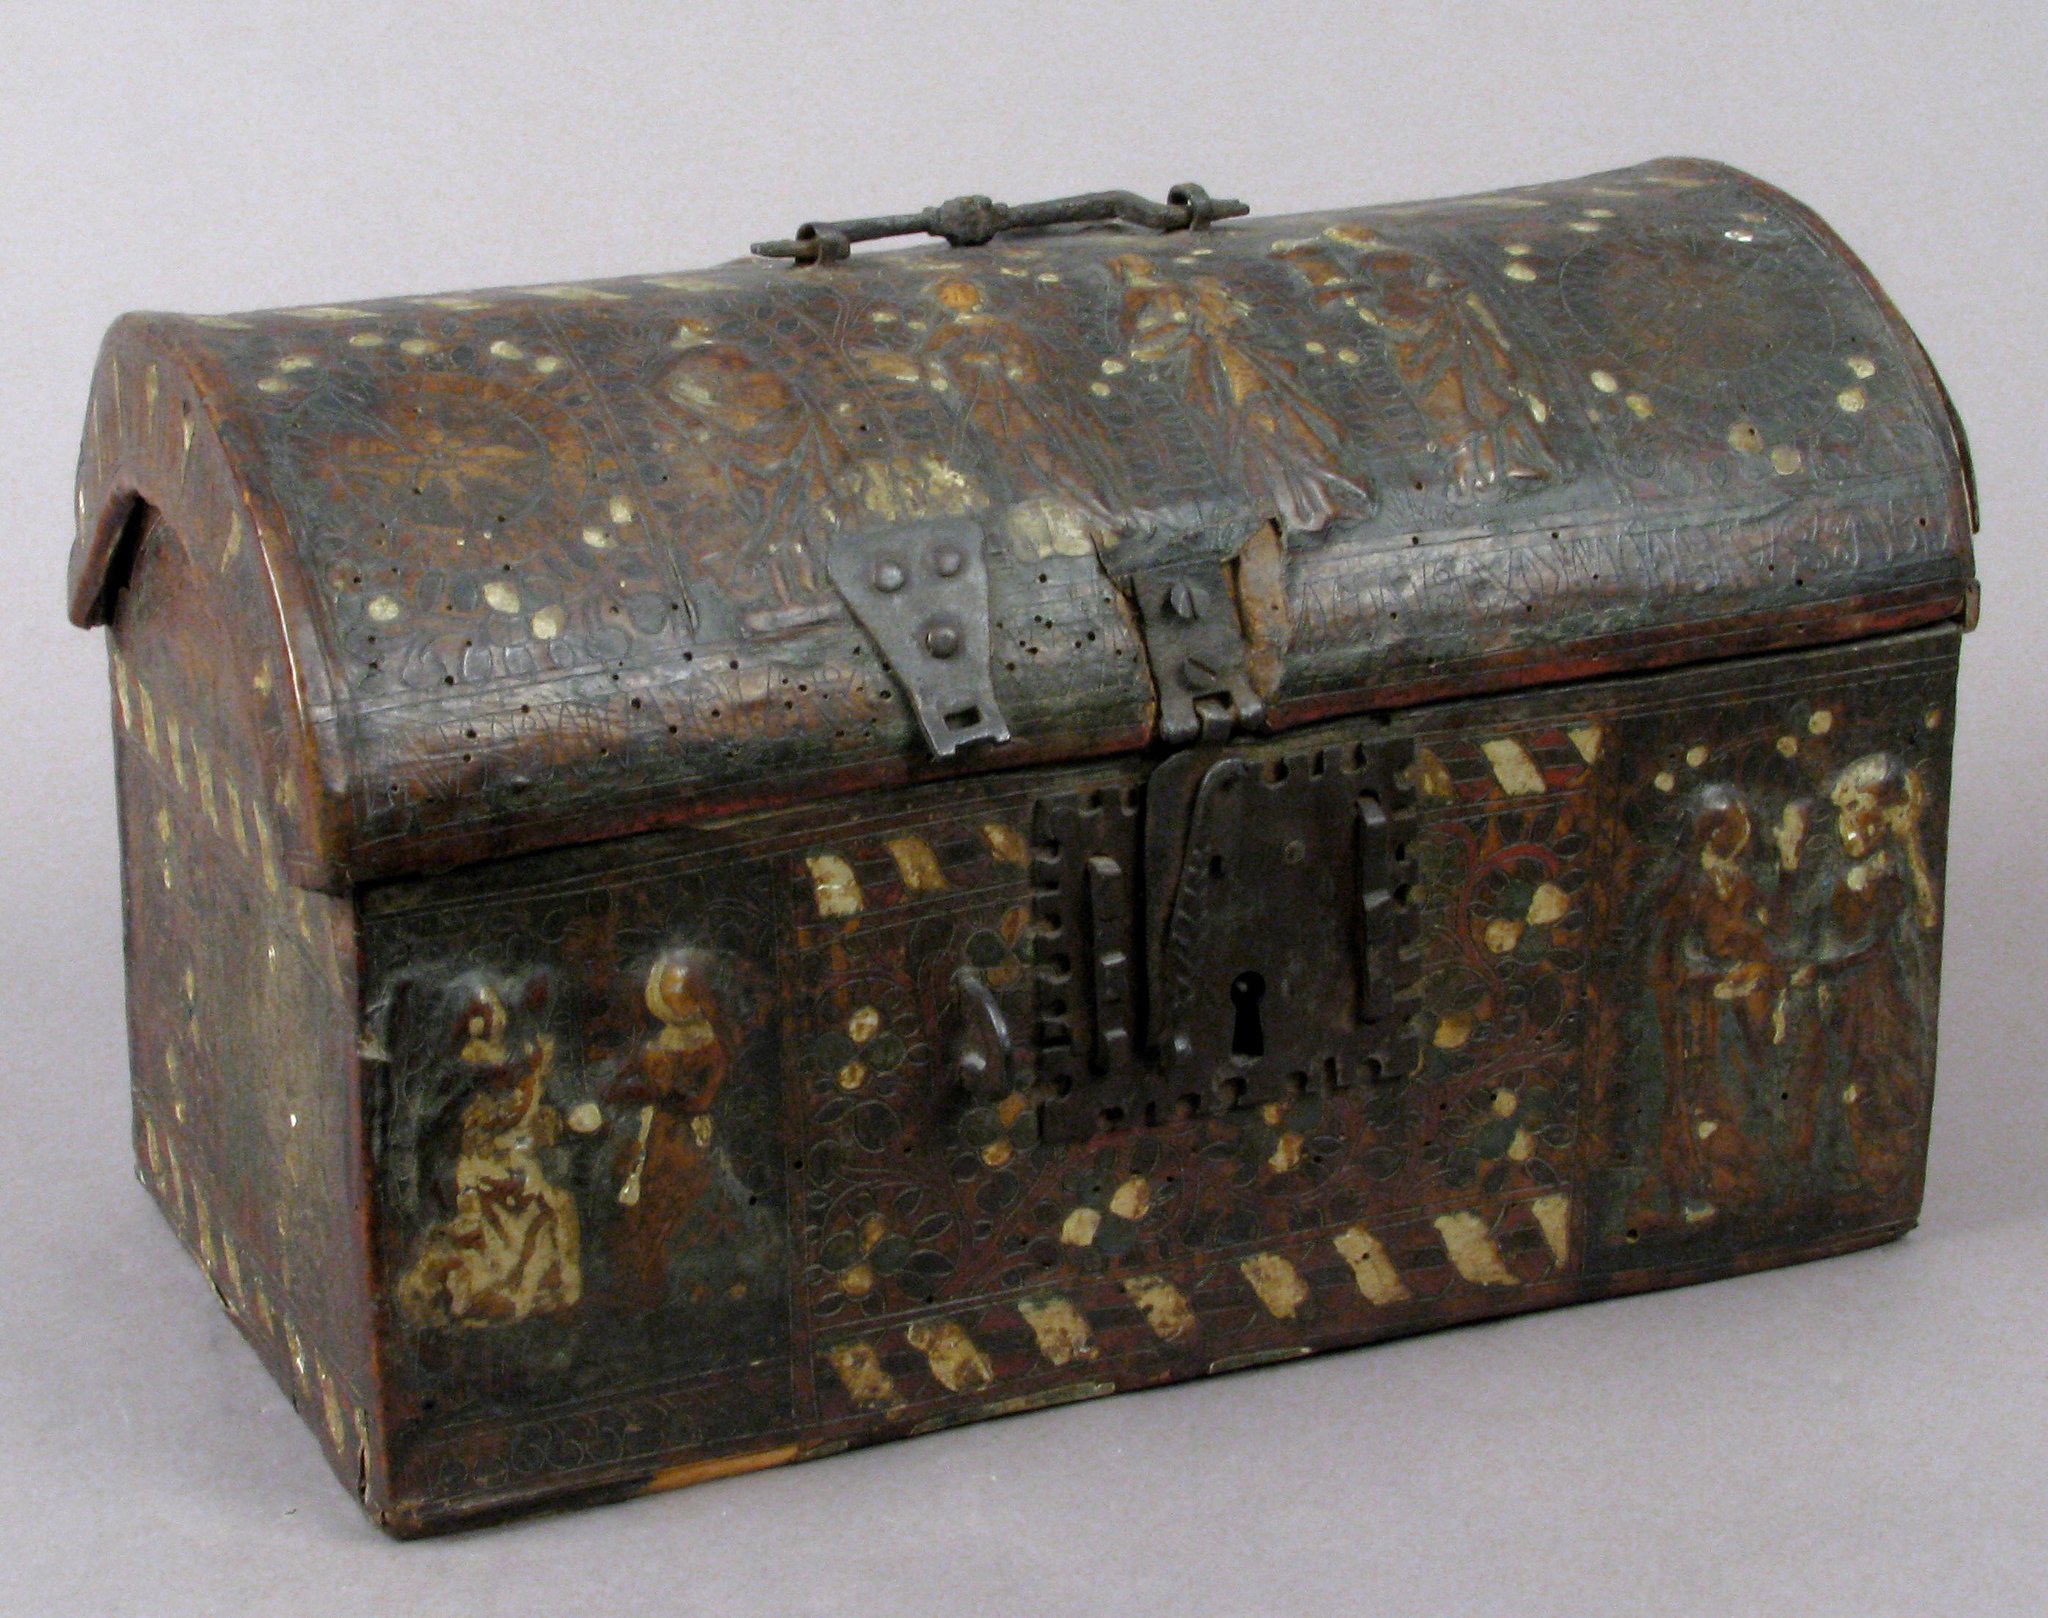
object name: coffret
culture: french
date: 1401-1500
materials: leather, metal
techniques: polychromy, stamping, tooling